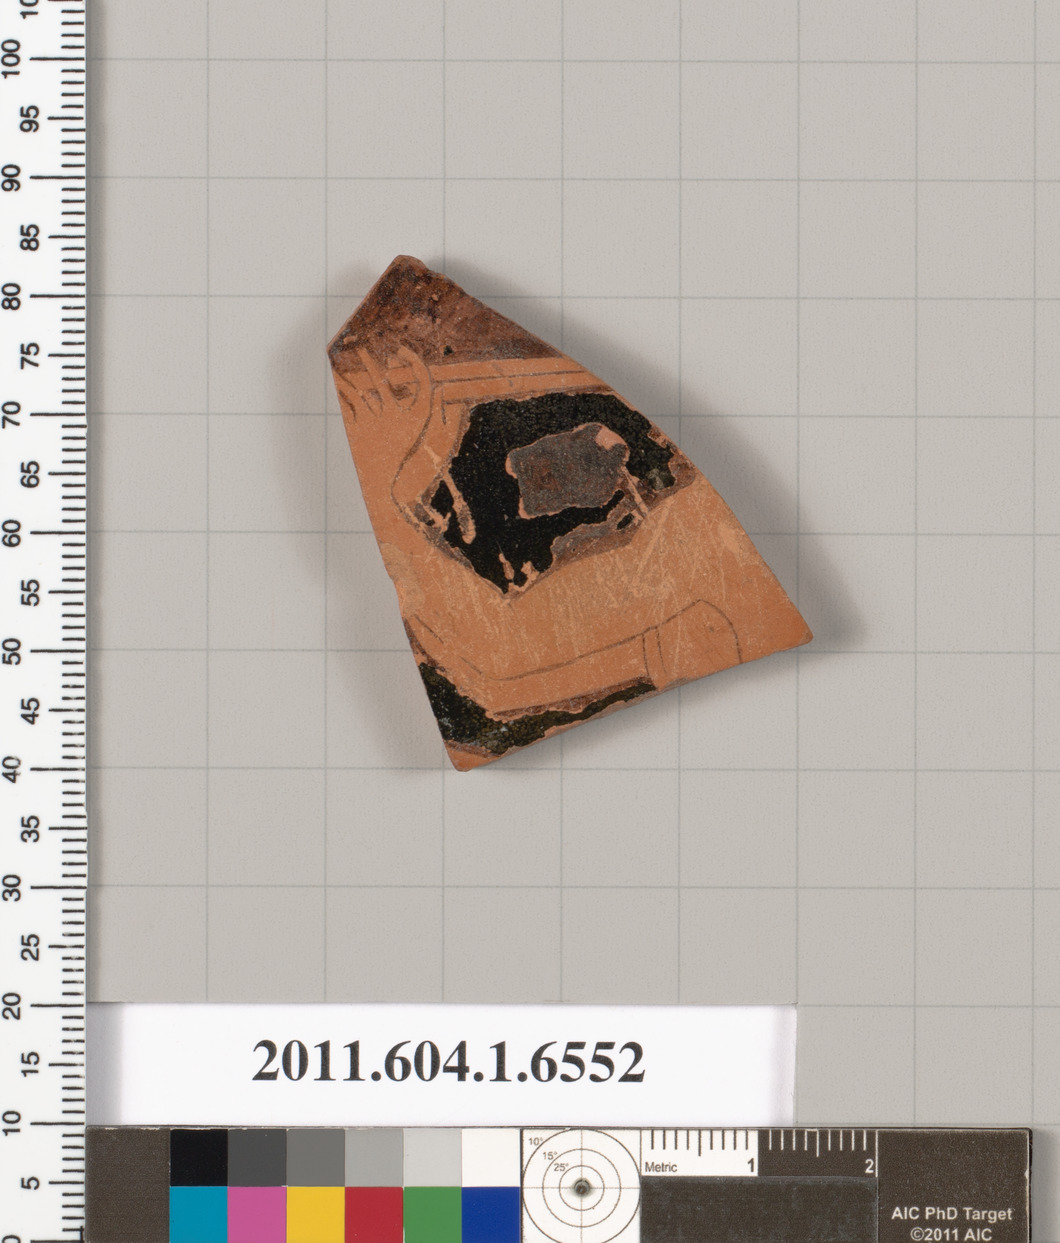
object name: kylix fragment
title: Terracotta fragment of a kylix (drinking cup)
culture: greek, attic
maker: colmar painter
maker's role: artist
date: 490-480 BCE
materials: terracotta